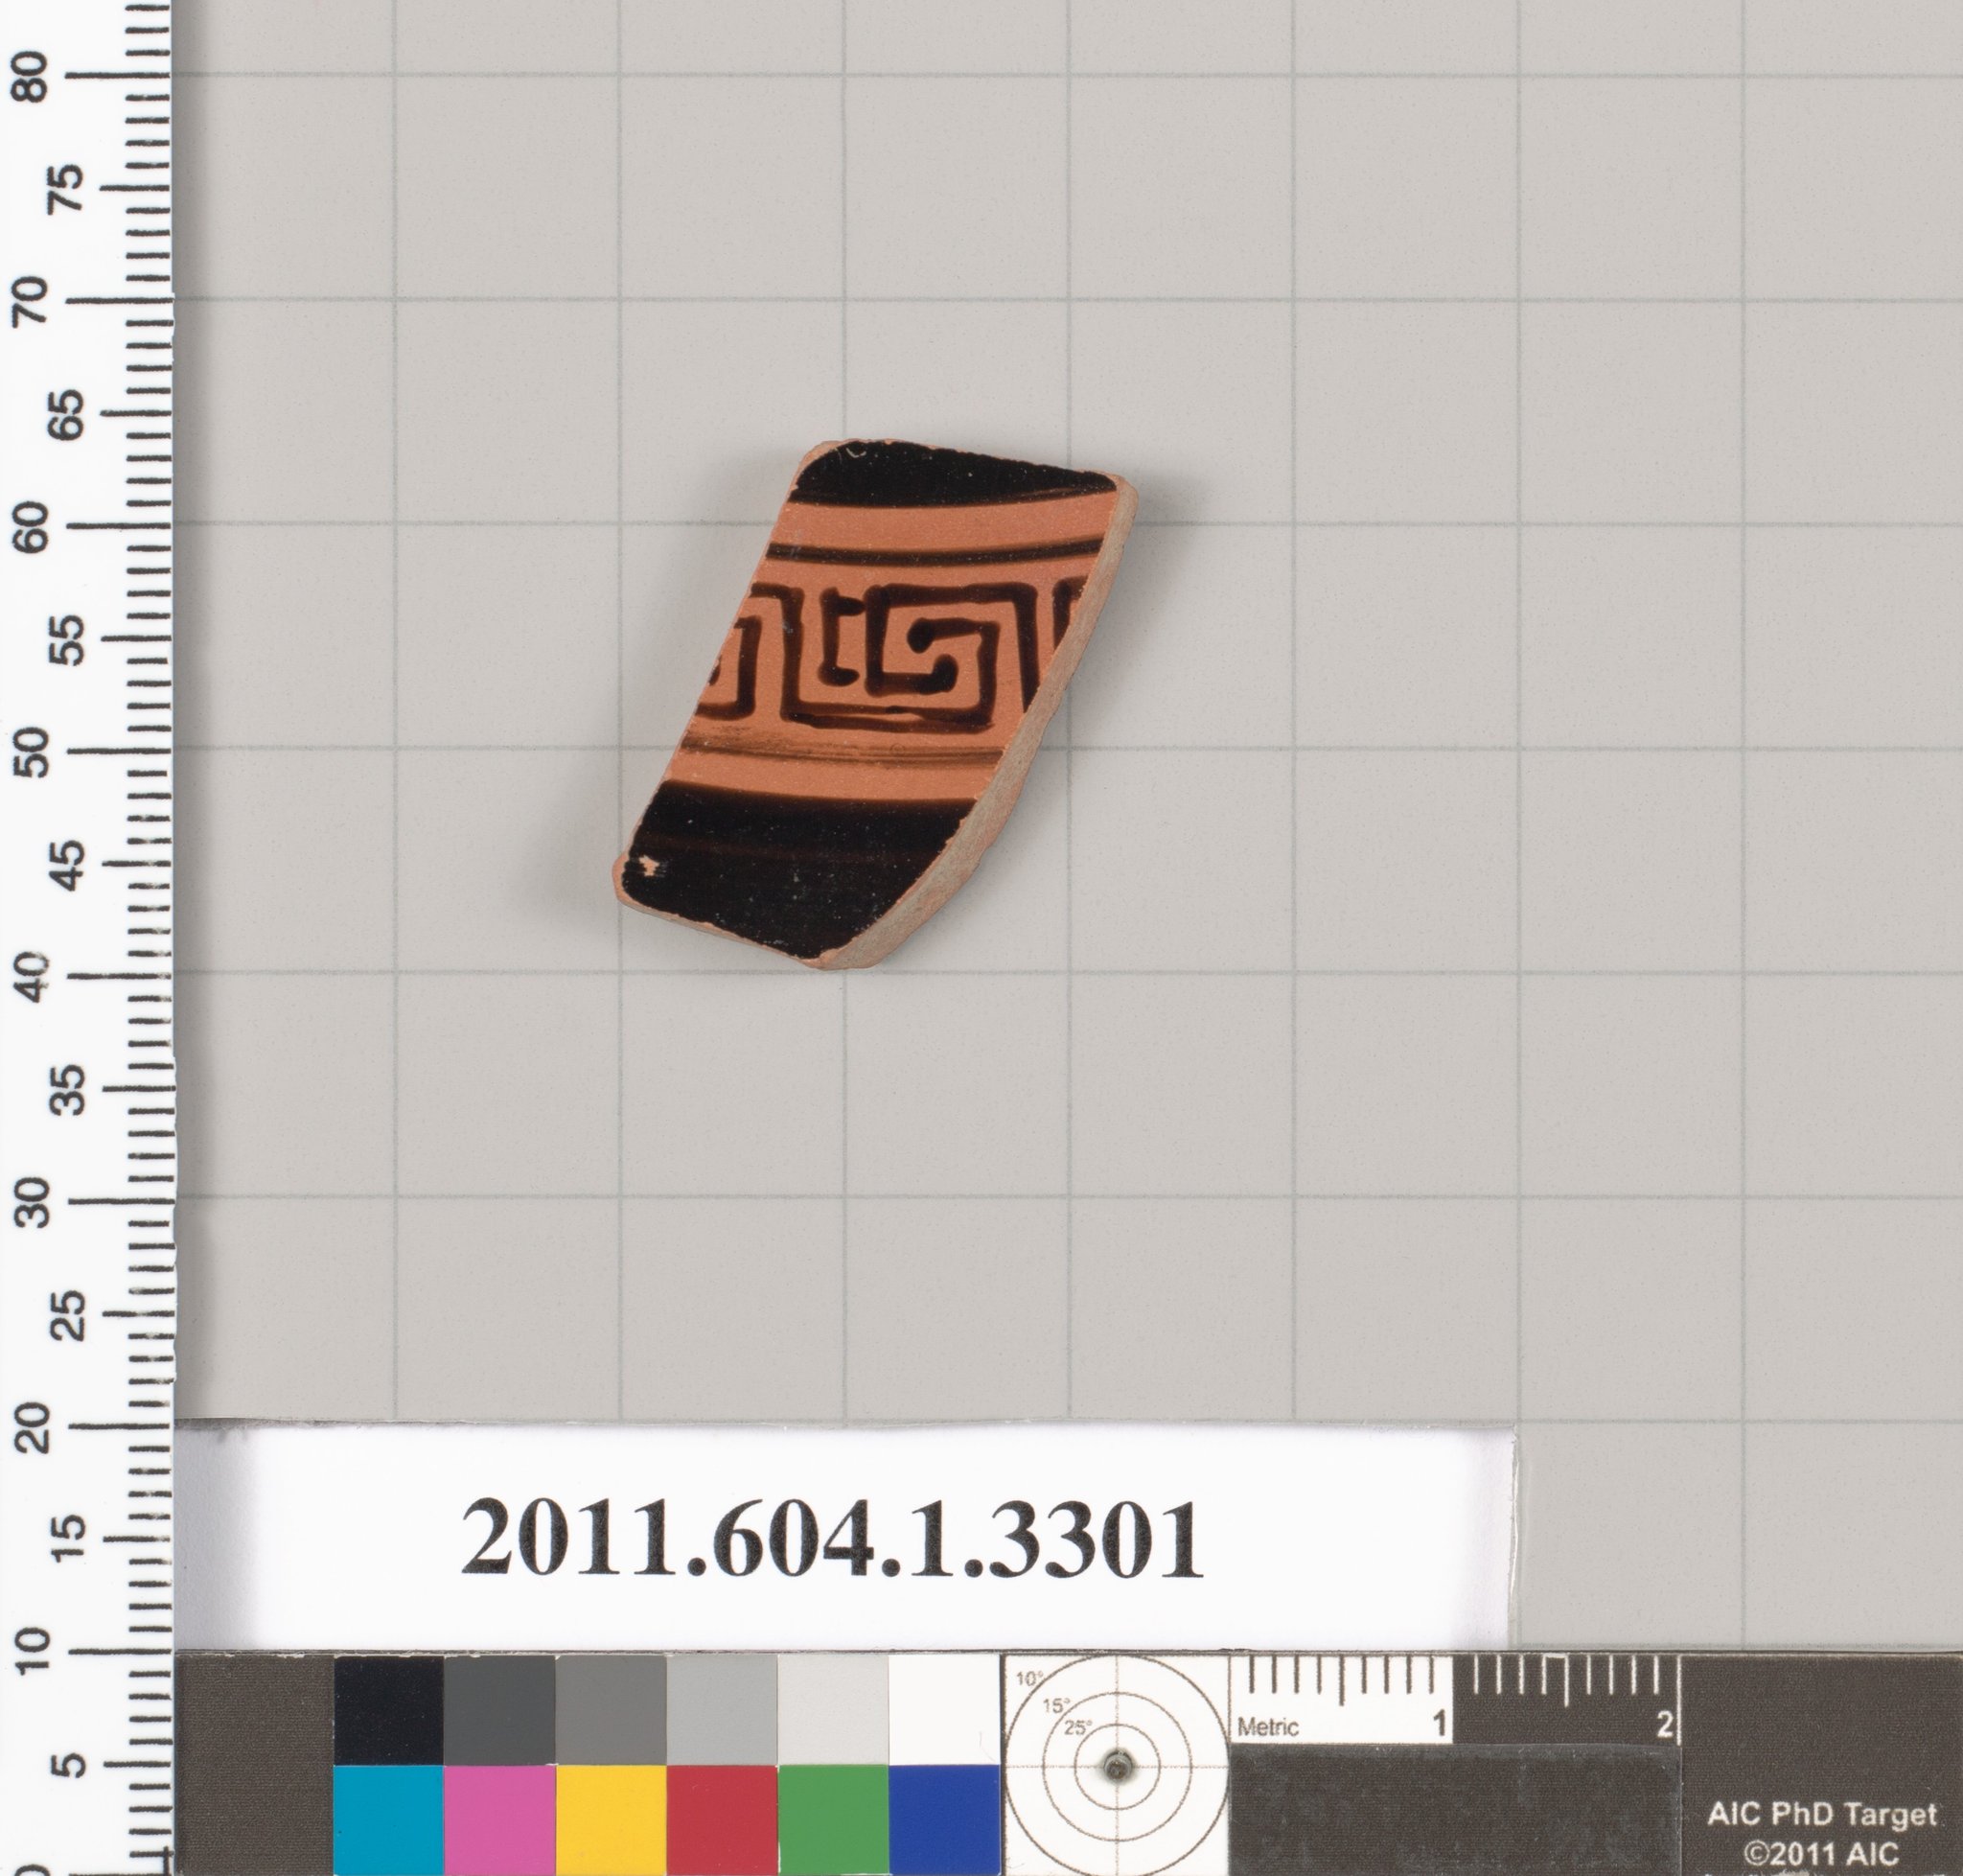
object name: kylix fragment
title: Terracotta fragment of a kylix (drinking cup)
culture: greek, attic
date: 500-480 BCE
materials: terracotta